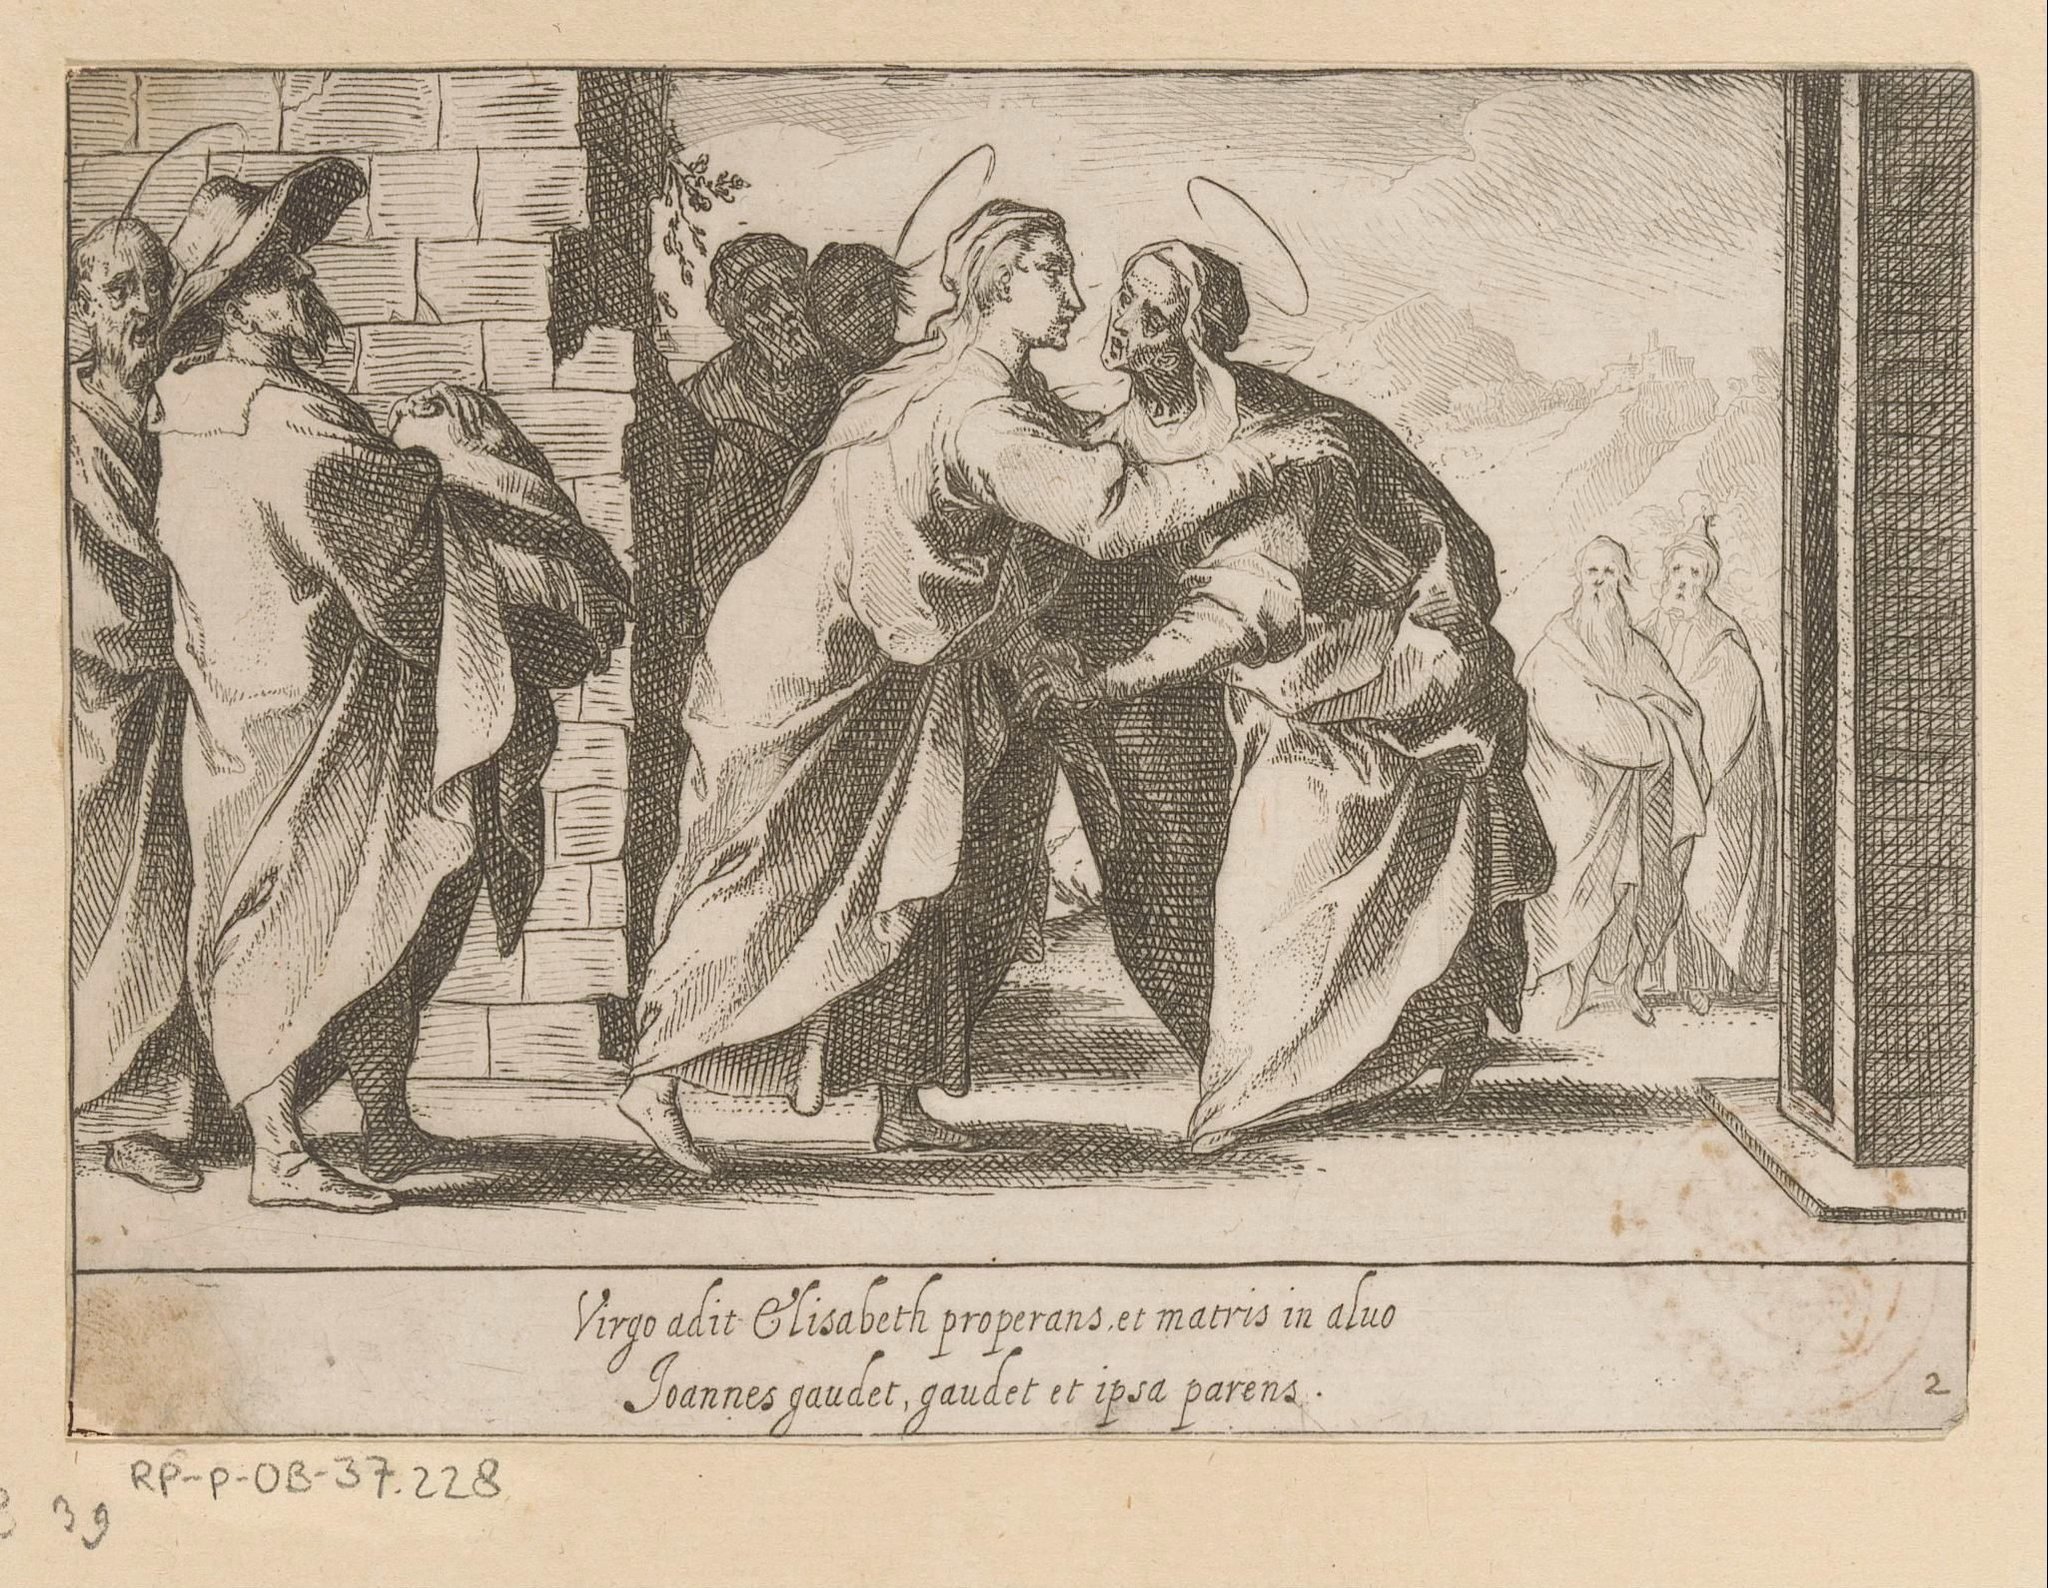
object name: print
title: Quindecim Mysteria Rosarii Beatae Mariae Virginis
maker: raffaello schiaminossi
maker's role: painter, print maker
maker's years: 1572-1622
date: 1602-1604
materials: paper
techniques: etching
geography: rome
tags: visitation (possibly joseph and/or zacharias present) (luke 1:39-56)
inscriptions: collector's mark: Lugt 240, number: ‘2’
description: De prent maakt deel uit van de serie 'Quindecim Mysteria Rosarii Beatae Mariae Virginis'. De serie bestaat uit een titelprent en vijftien prenten met voorstellingen van de Mysteries van de Rozenkrans (episodes uit de levens van Christus en Maria). In een andere staat is de prent in de plaat genummerd linksonder: 2.